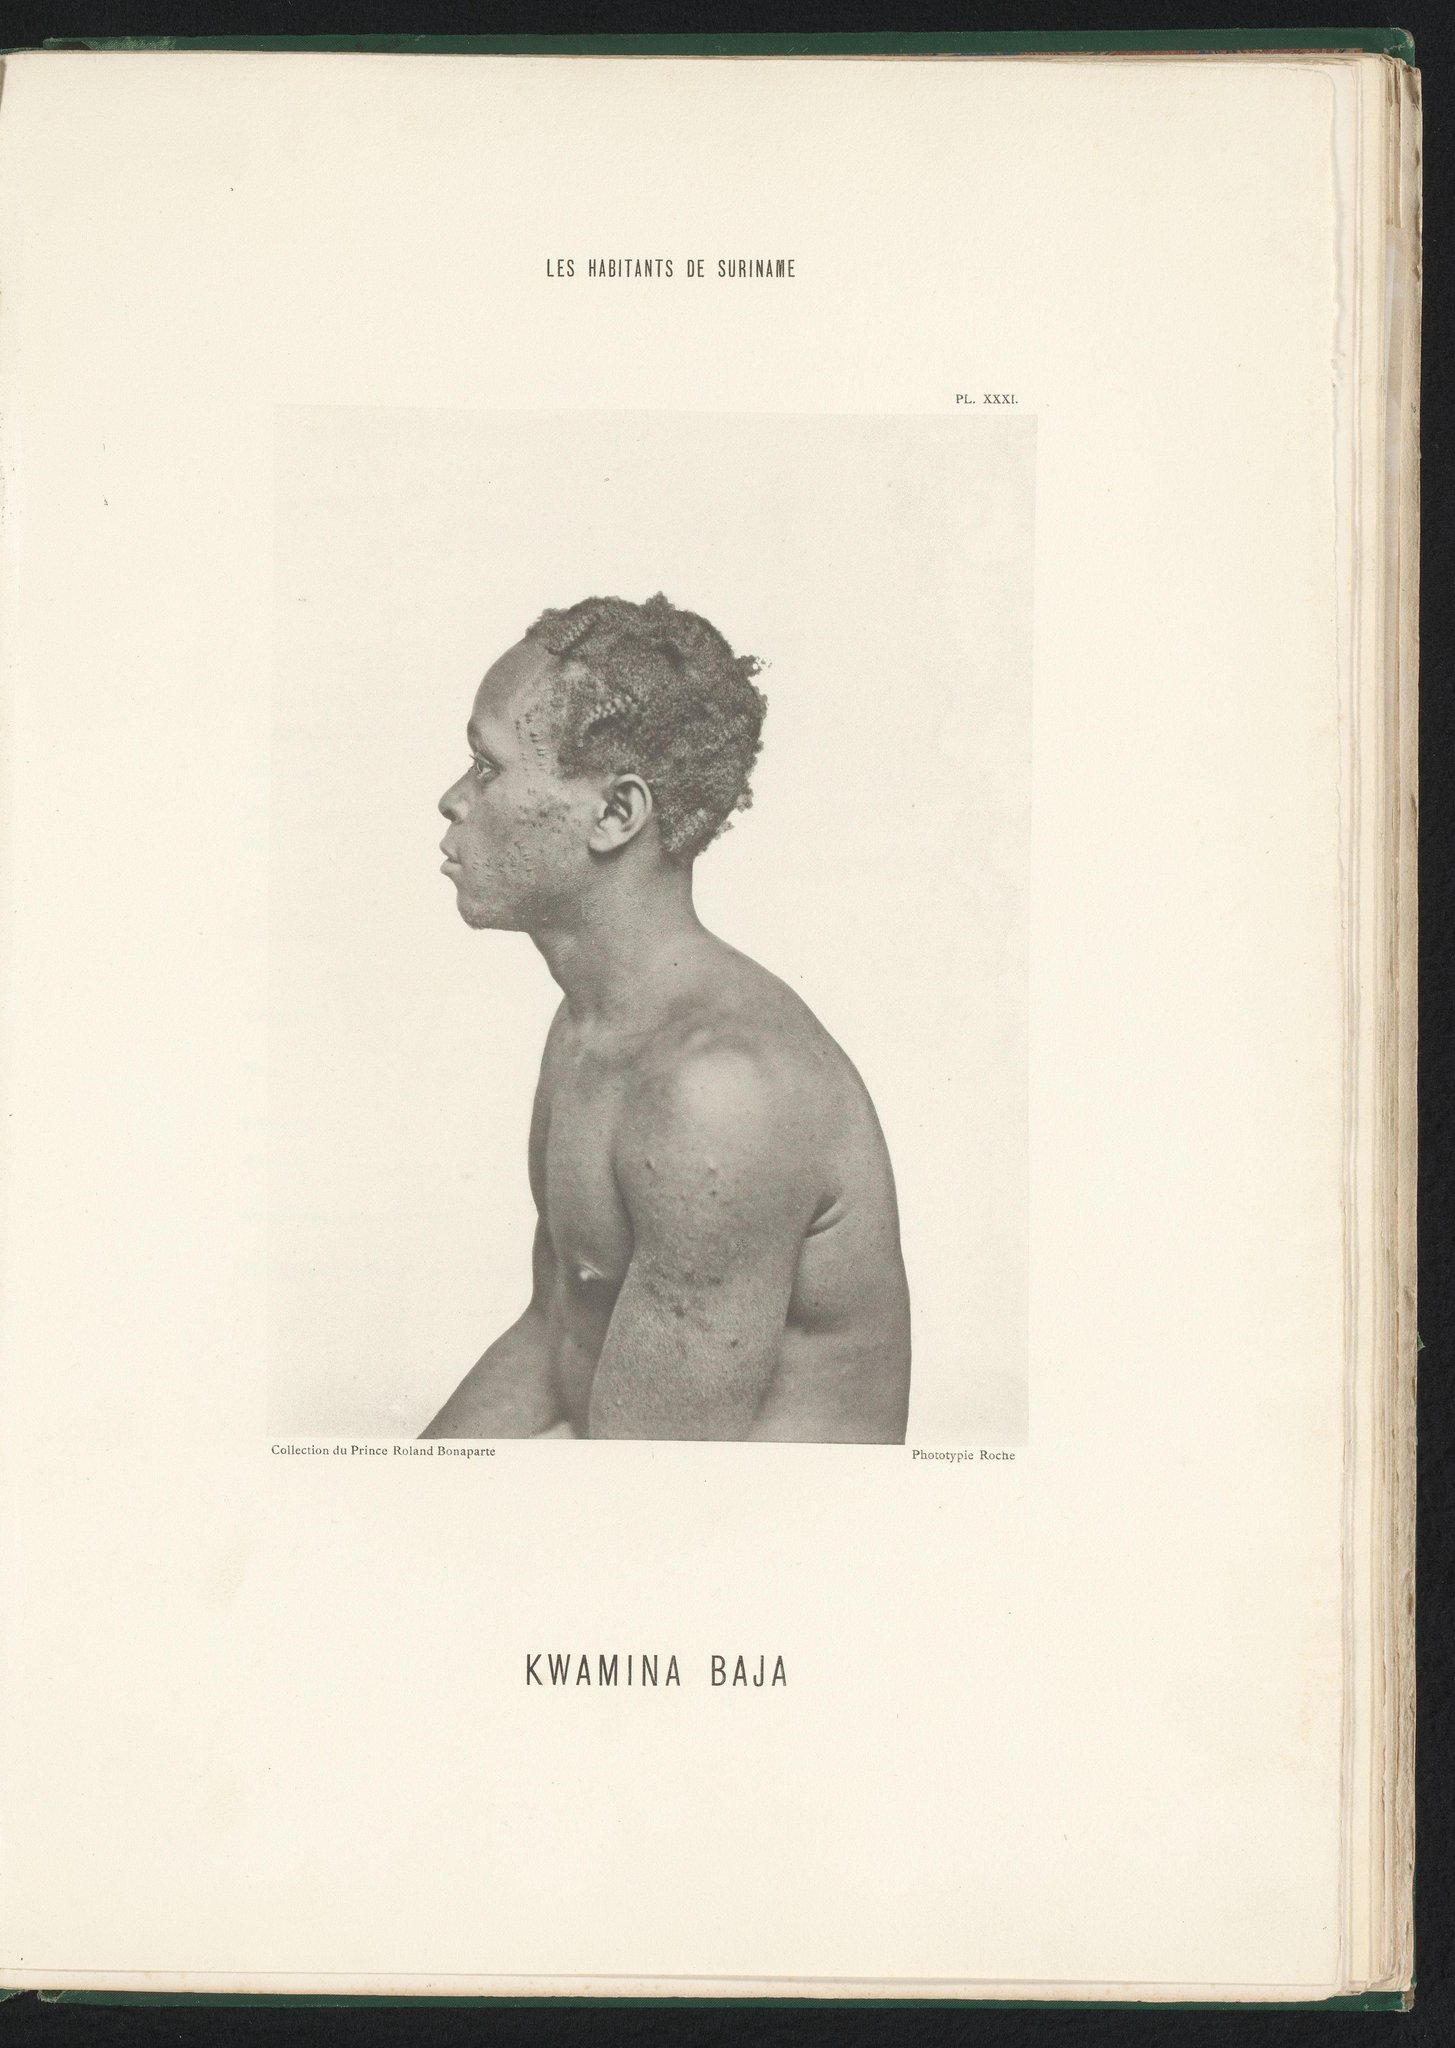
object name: page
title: Portret van Kwamina Baja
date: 1883-1884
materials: paper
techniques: photograph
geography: amsterdam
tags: adult man, historical persons, amsterdam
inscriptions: inscription: ‘Collection du Prince Roland Bonaparte/ Phototypie Roche’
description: Portret van Kwamina Baja, een Saramaccaner Marron uit Suriname, gefotografeerd op de Internationale Koloniale en Uitvoerhandel Tentoonstelling, Amsterdam 1883.